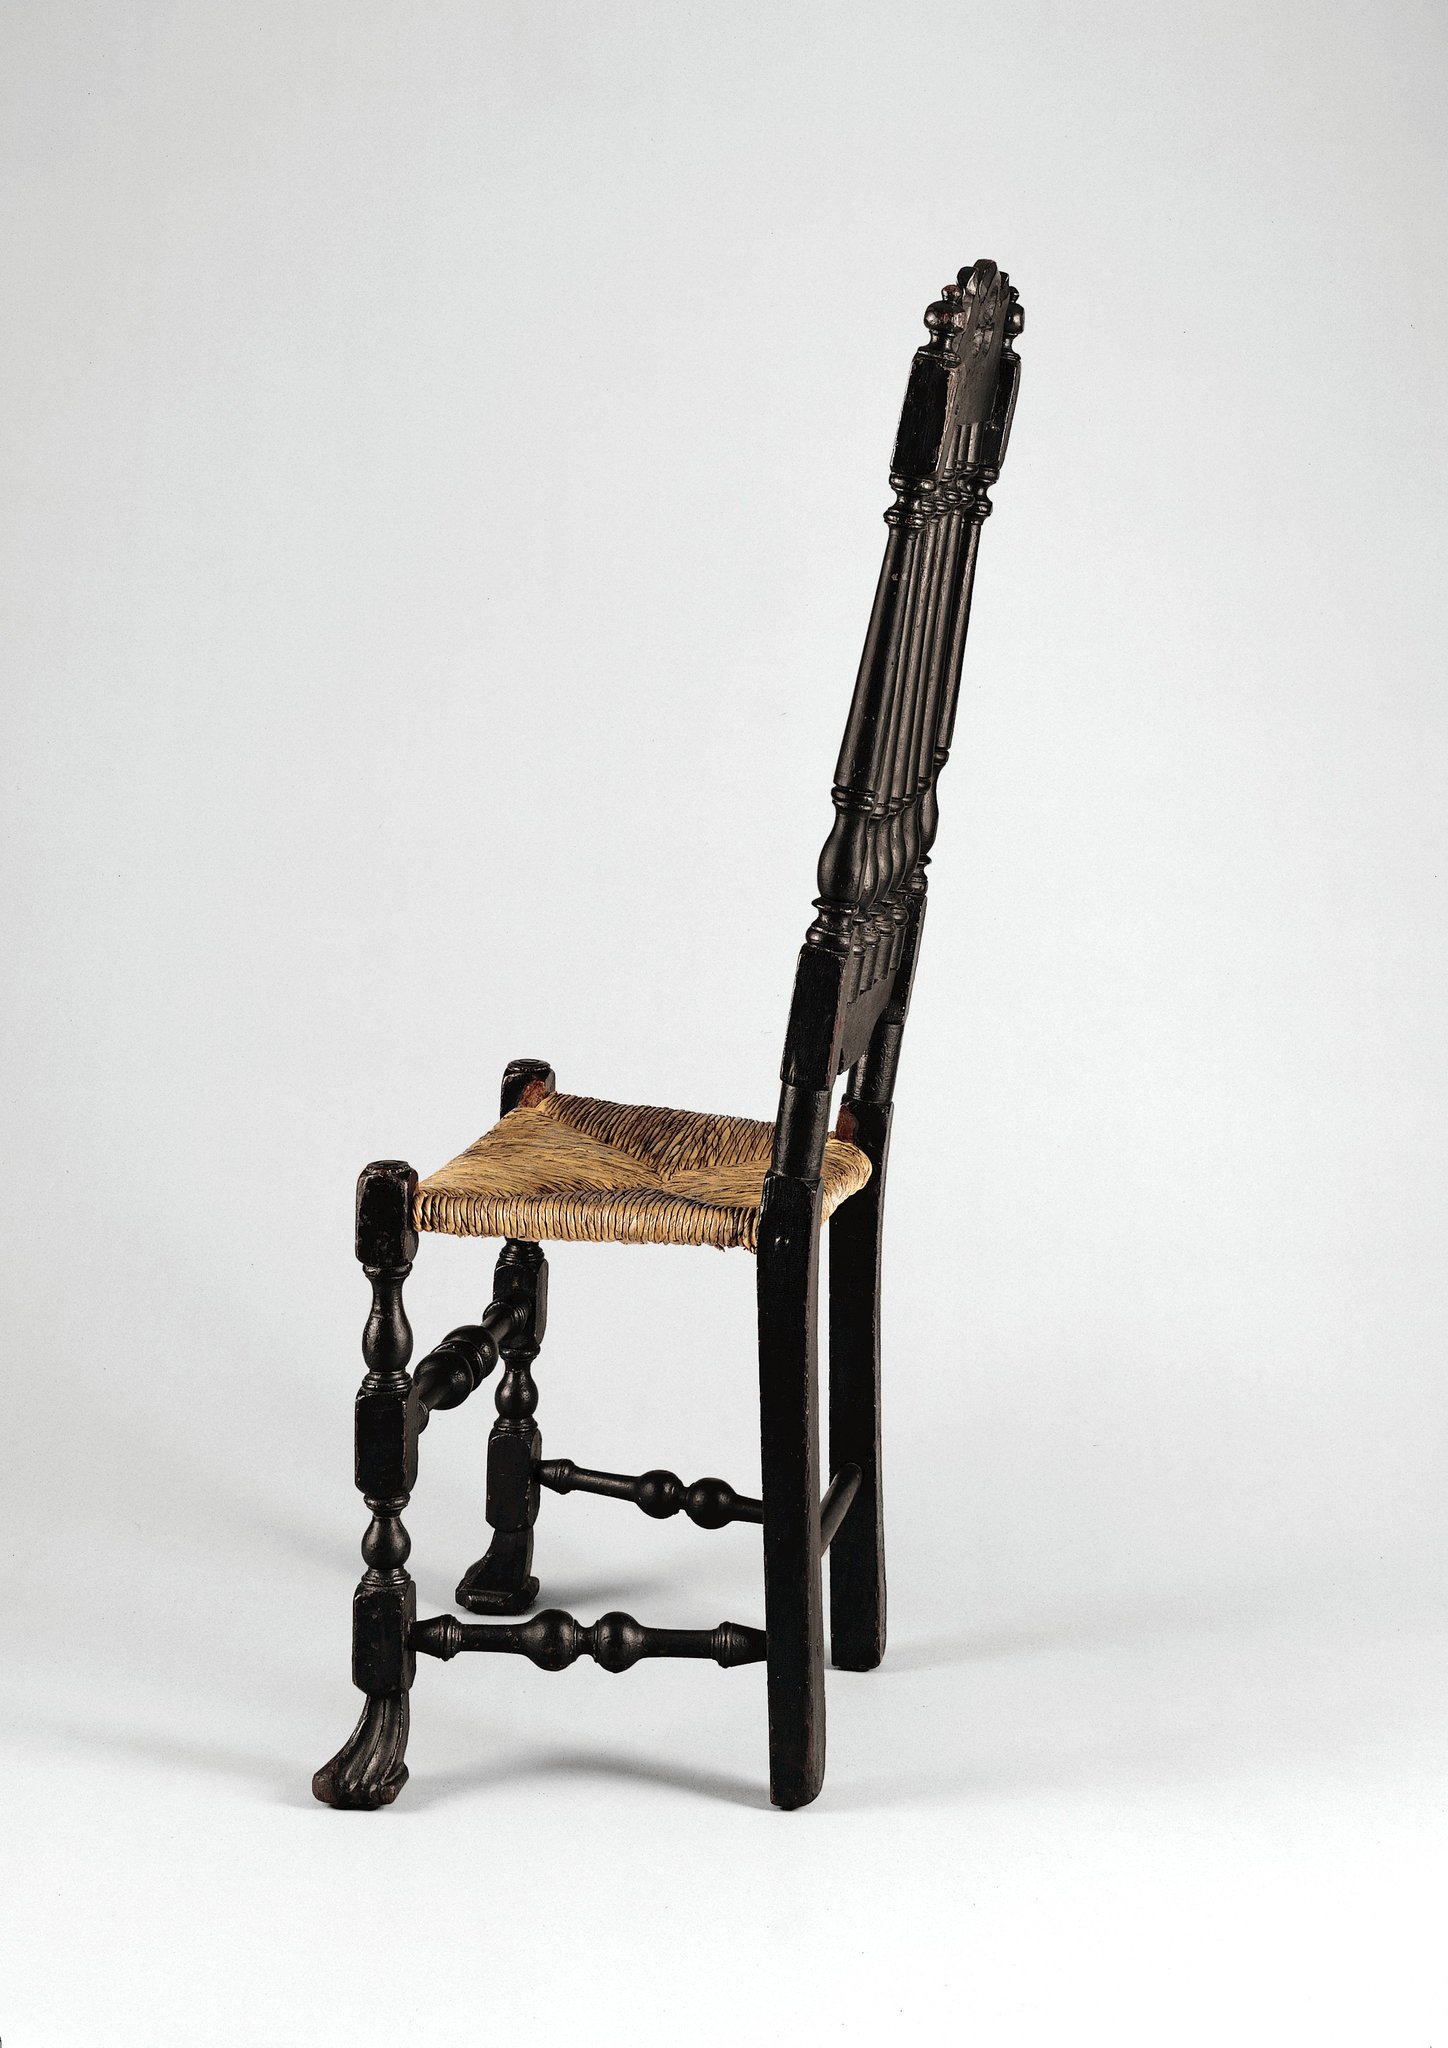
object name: banister back chair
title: Banister-back chair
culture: american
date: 1715-1735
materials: wood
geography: united states